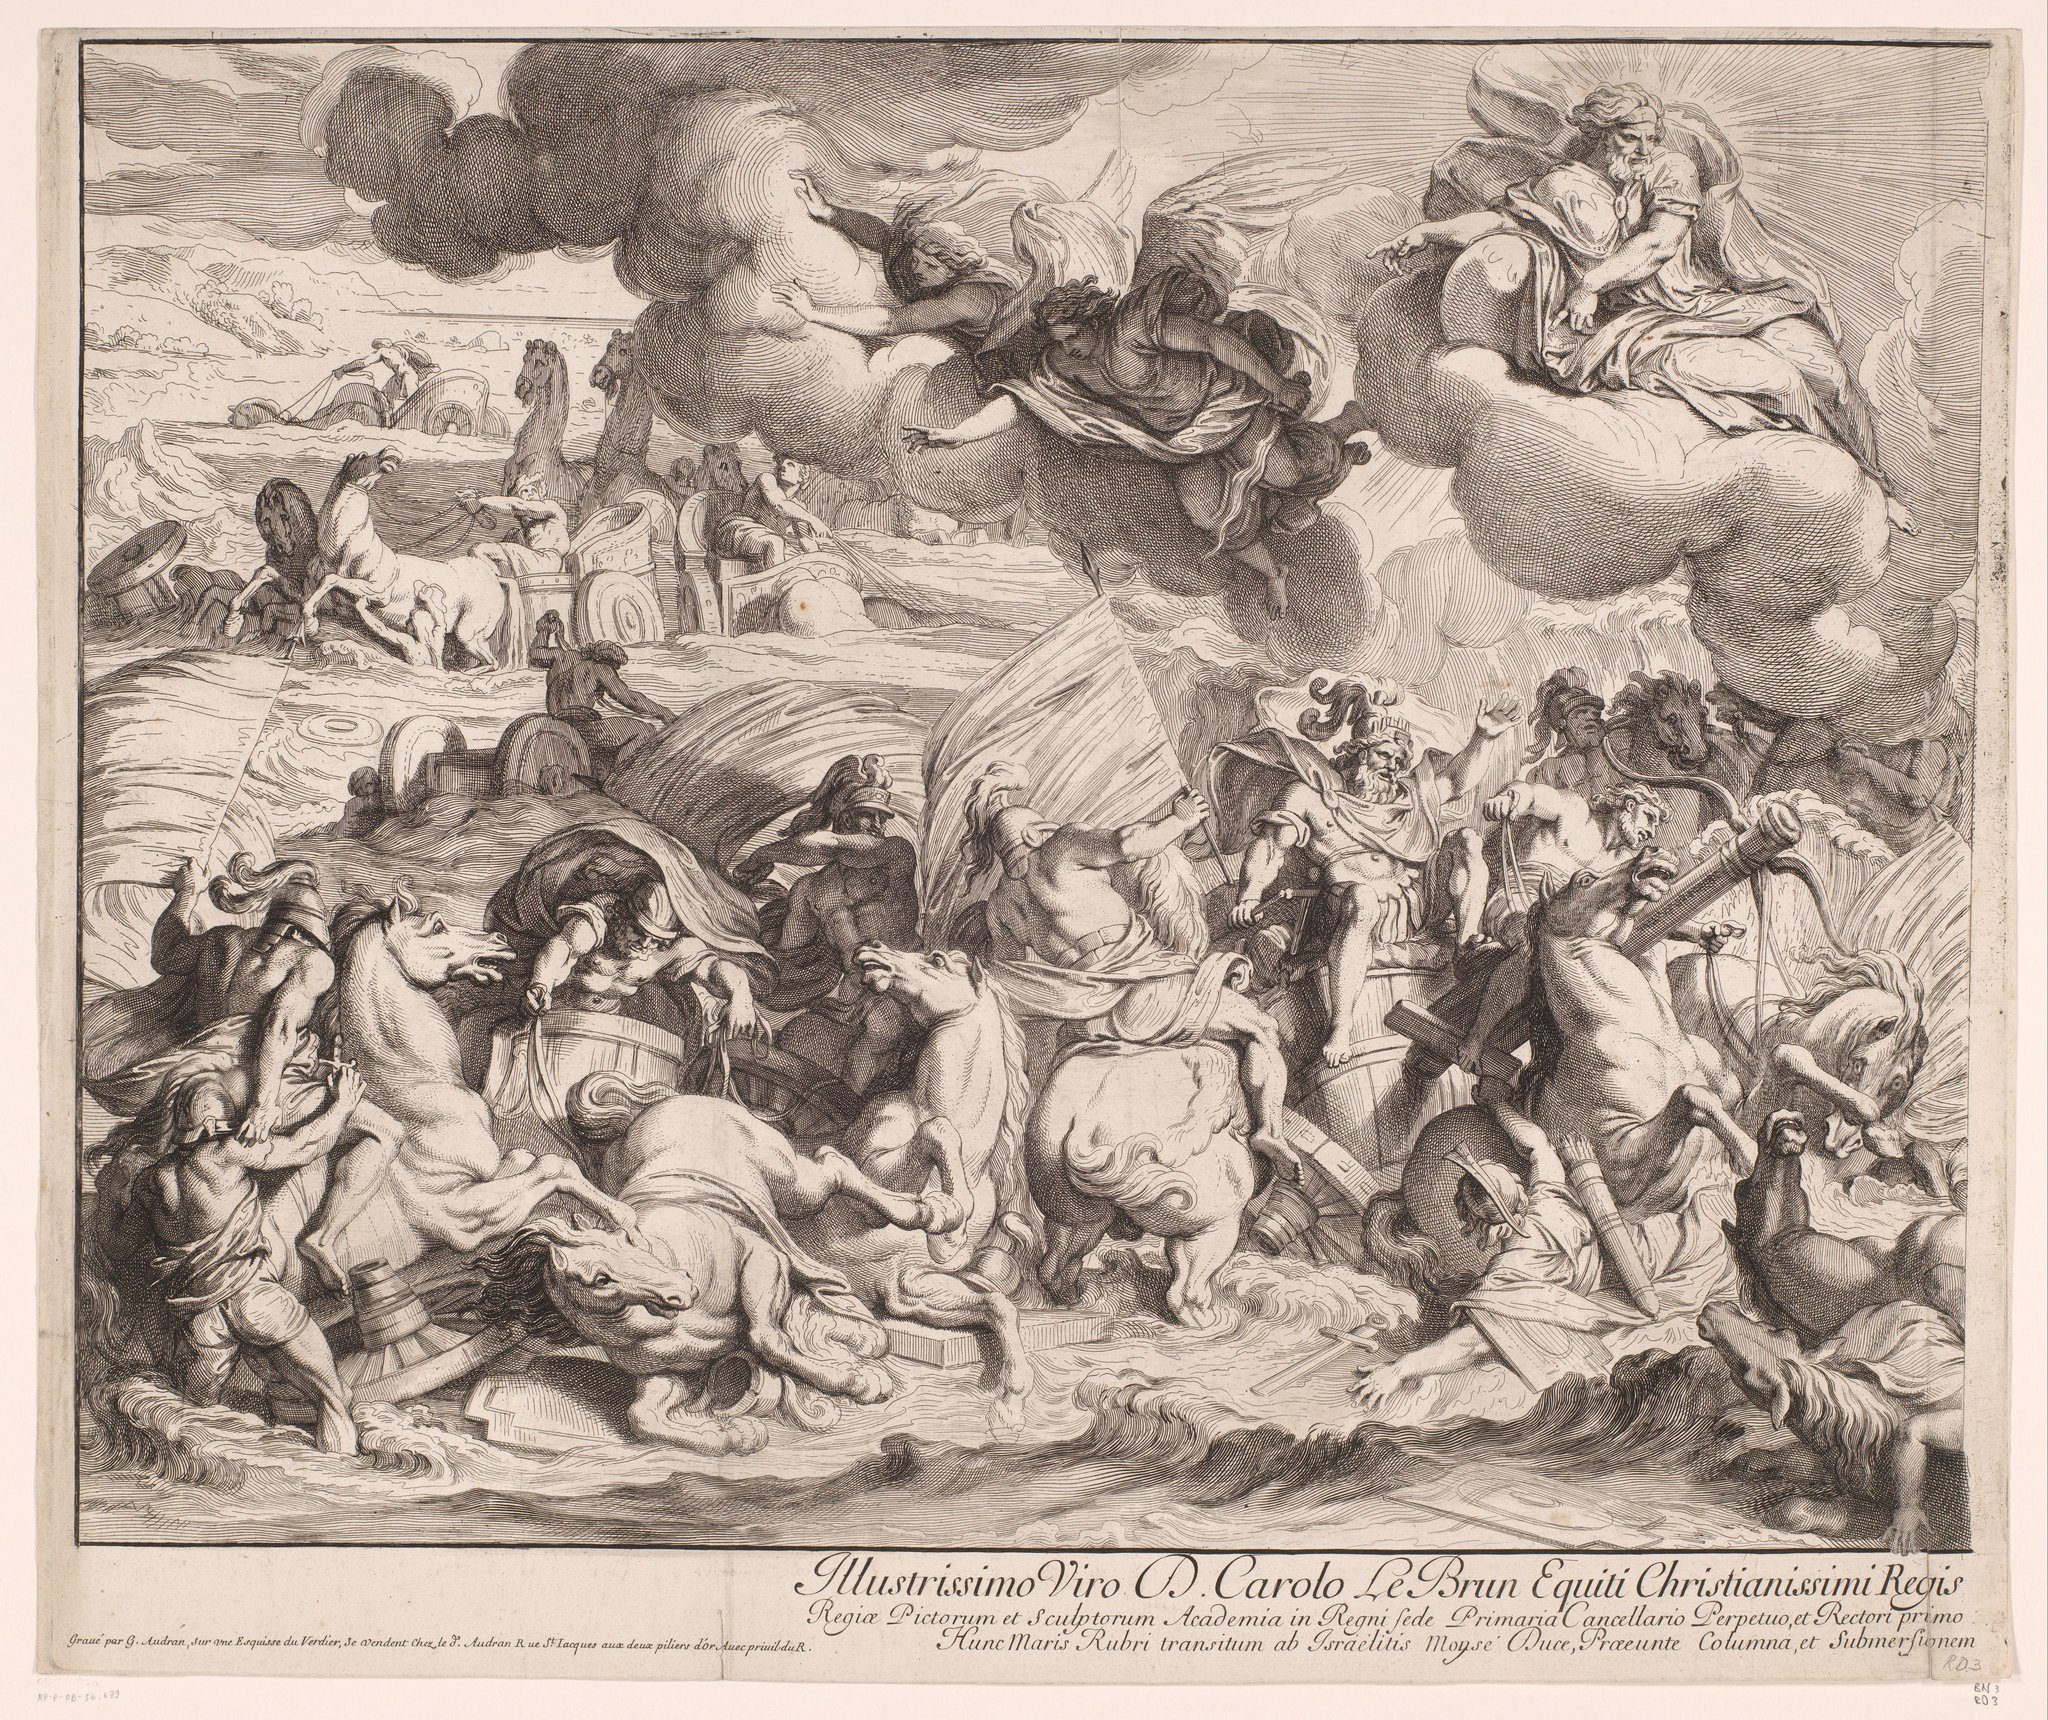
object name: print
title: Doortocht door de Rode Zee (linkerdeel)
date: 1676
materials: paper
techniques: engraving, etching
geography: paris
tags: with his people safe on the shore, moses raises his hands and causes the water to return; pharaoh's army perishes in the water (red sea)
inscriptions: watermark, collector's mark: Lugt 240